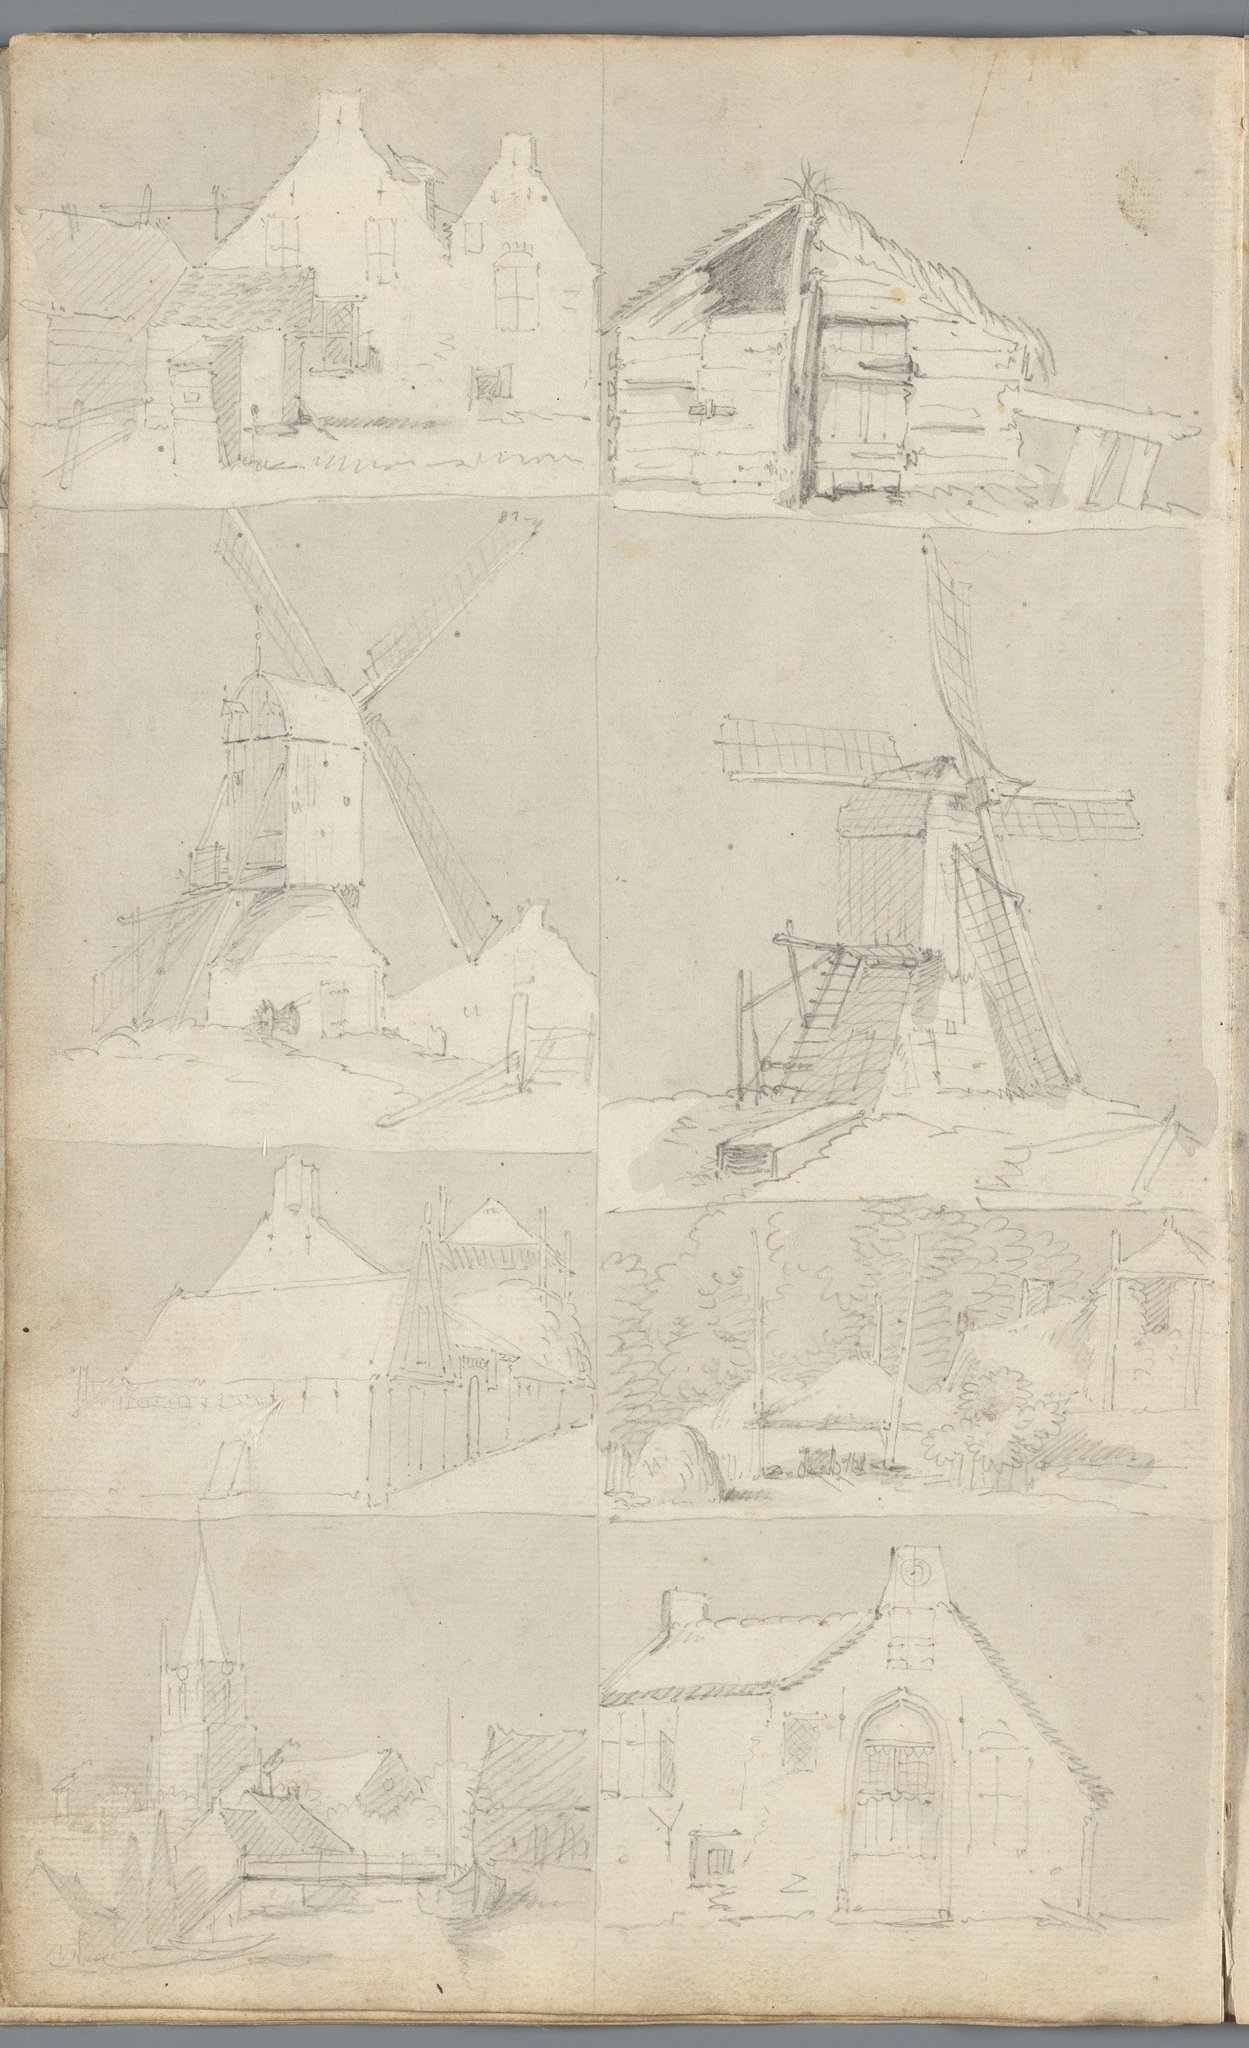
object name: sketchbook leaf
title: Boerderijen en molens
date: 1780-1800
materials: ink, paper, pencil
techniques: brush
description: Blad 7 verso uit een schetsboek met 17 bladen.